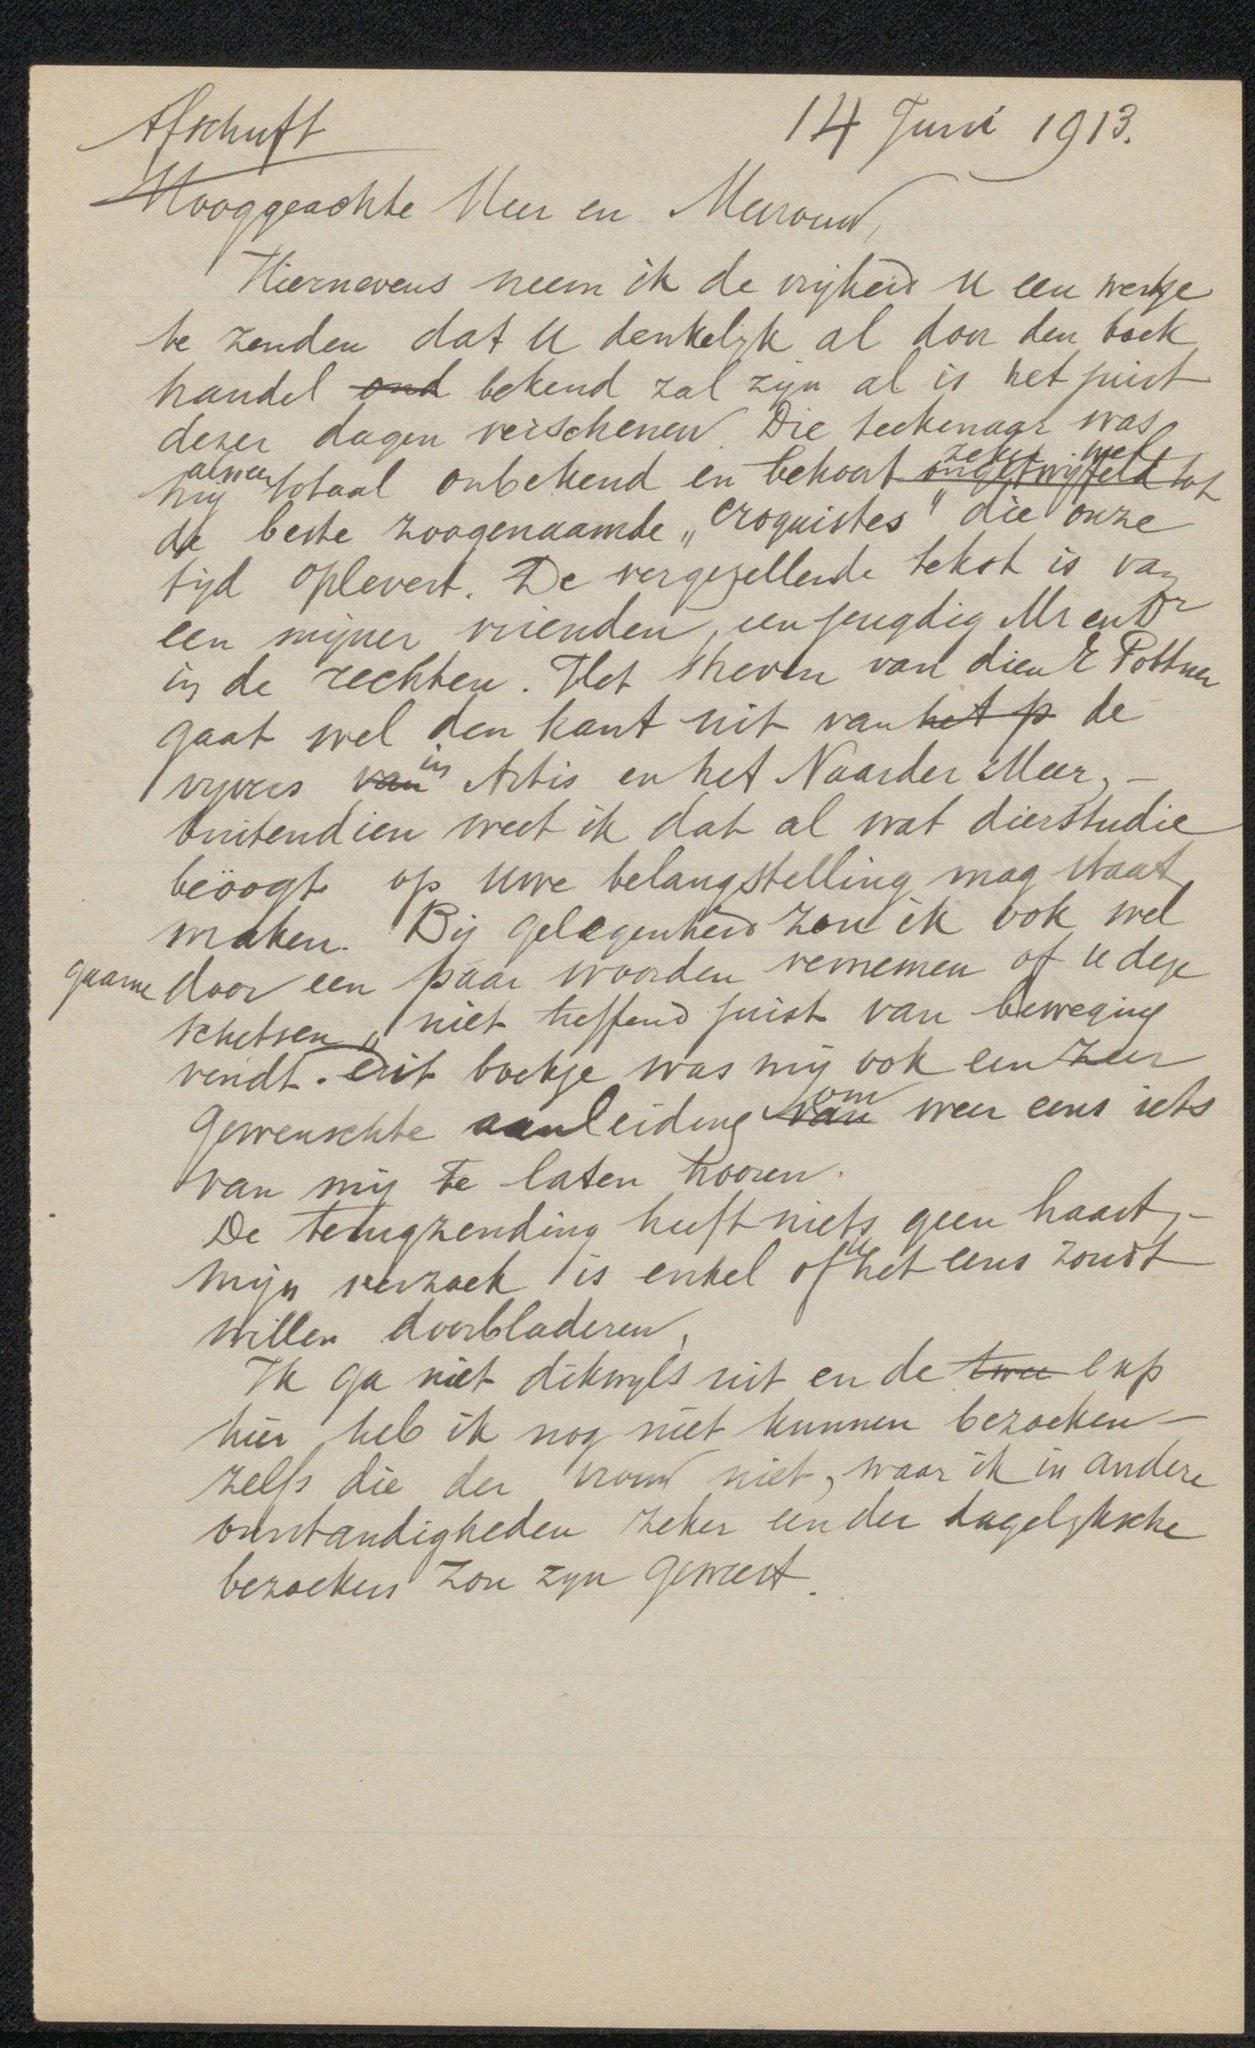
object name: letter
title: Brief aan anoniem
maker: august allebé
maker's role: draughtsman, print maker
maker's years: 1838-1927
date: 1913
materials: ink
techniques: pen, writing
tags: drawing